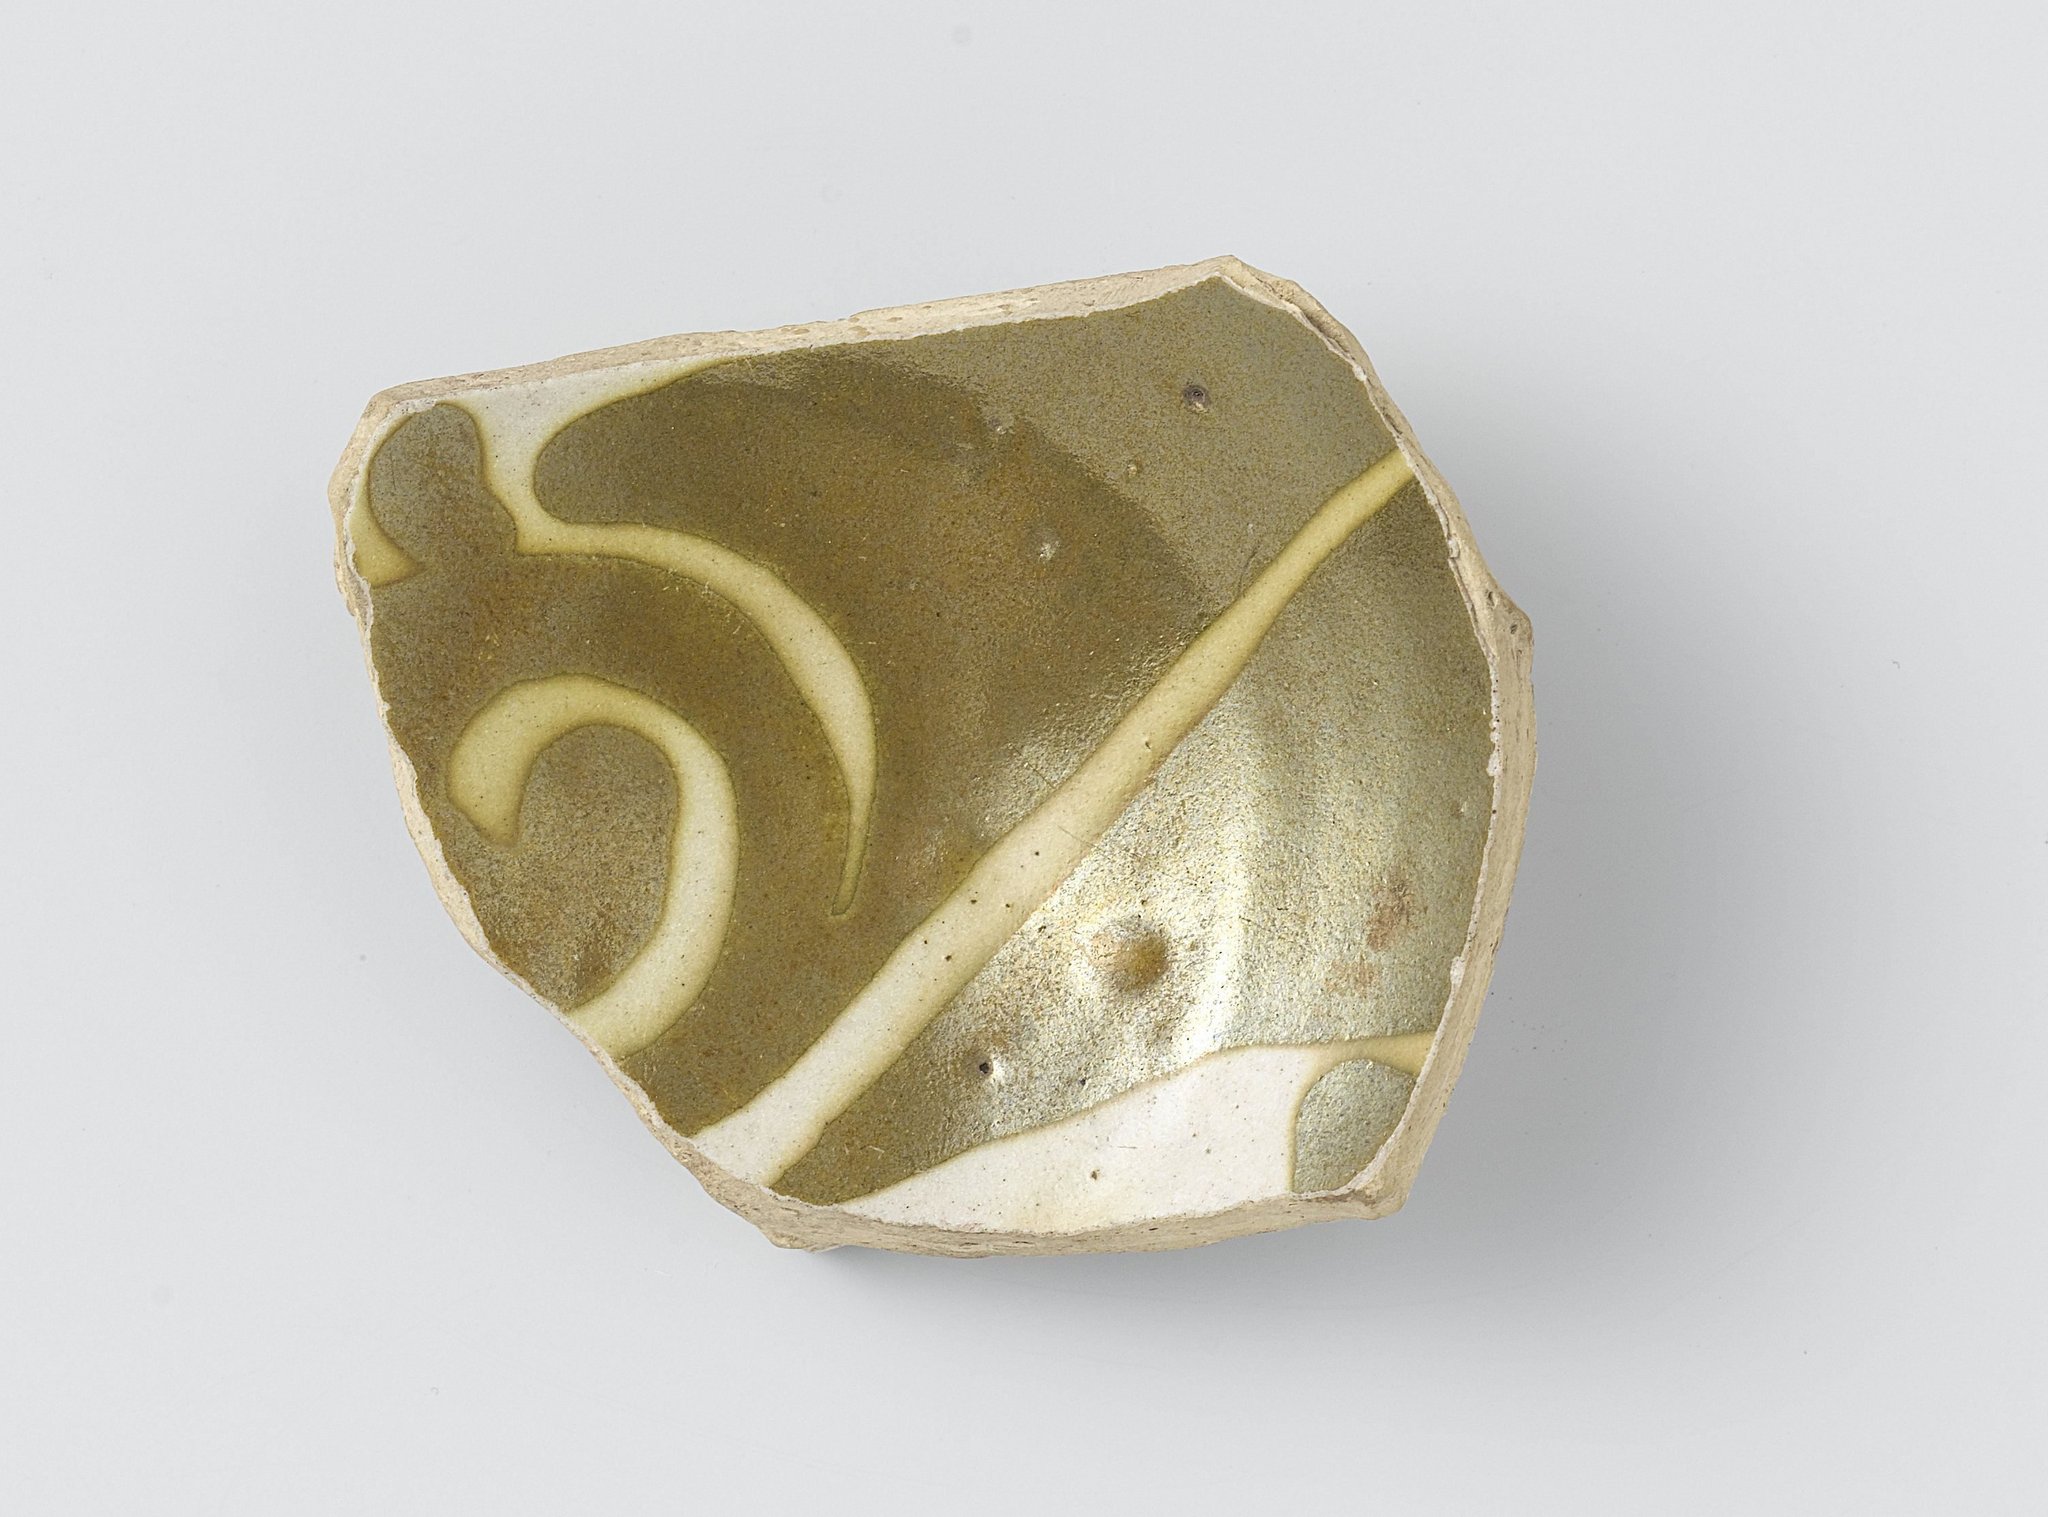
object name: fragment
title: Dish fragment with an ornament in luster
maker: Anonymous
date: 1200-1249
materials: earthenware, glaze, luster, paint, quartz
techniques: firing, turning, vitrification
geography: syria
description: Fragment van een schotel van kwarts-fritgoed, voor het grootste deel versierd met een ornament in bruinachtig luster. Tamelijk harde witte aarde met roomkleurige glazuur.